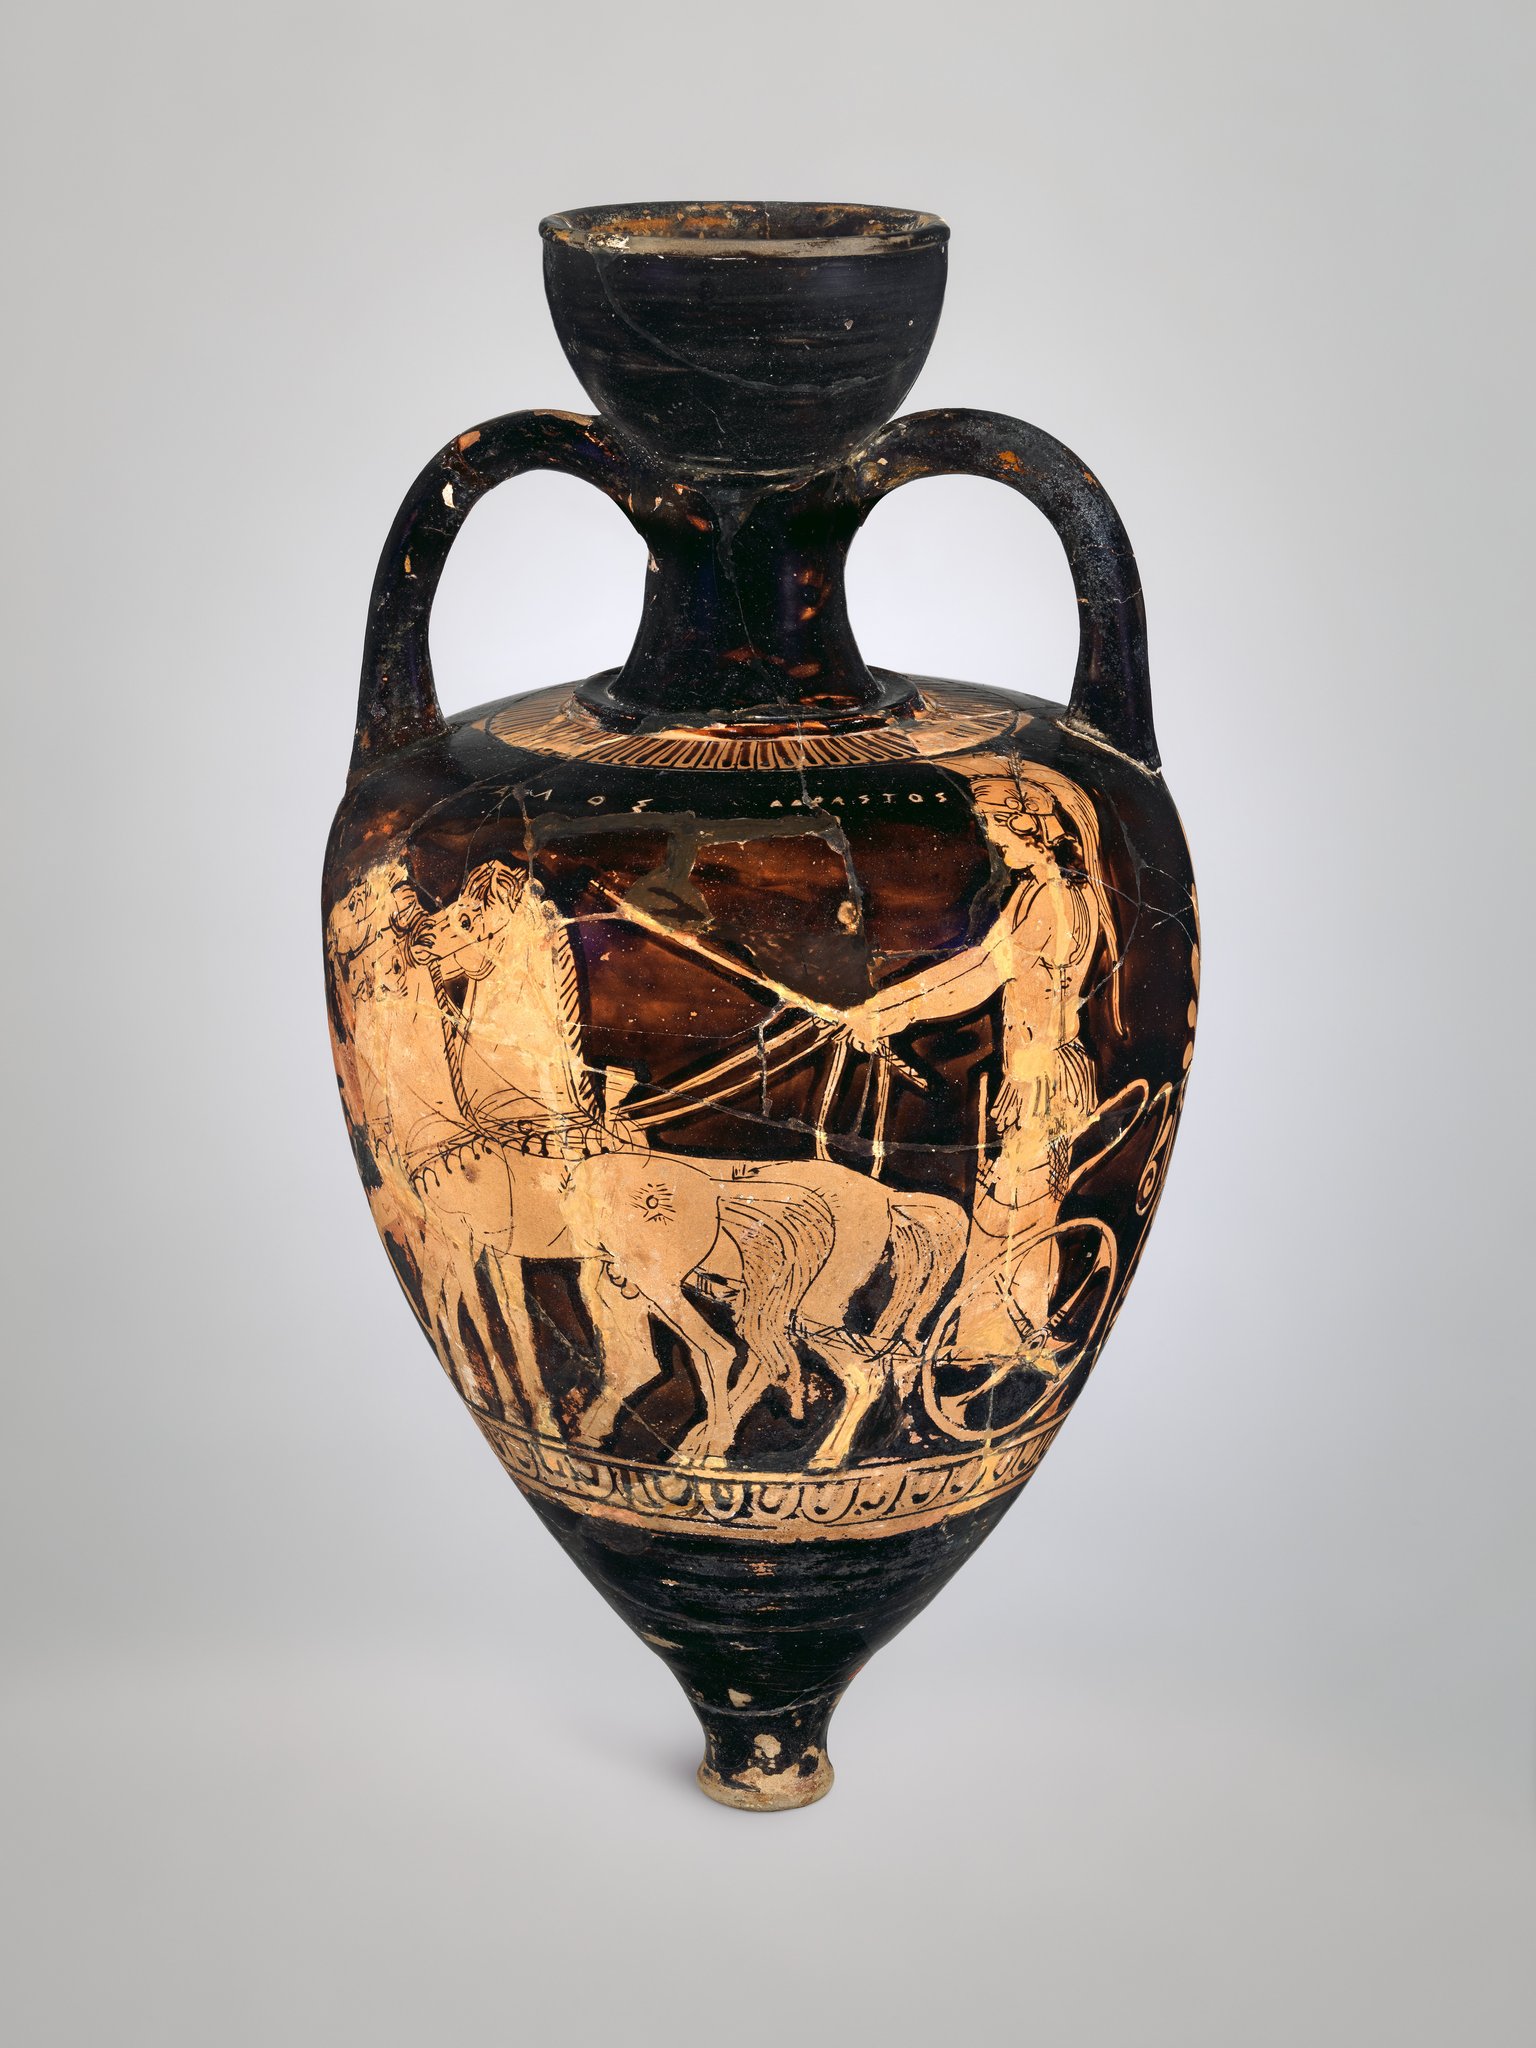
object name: amphoriskos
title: Terracotta amphoriskos (flask)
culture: greek, attic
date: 420 BCE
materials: terracotta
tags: men,women,apollo,horses,chariots,lyres